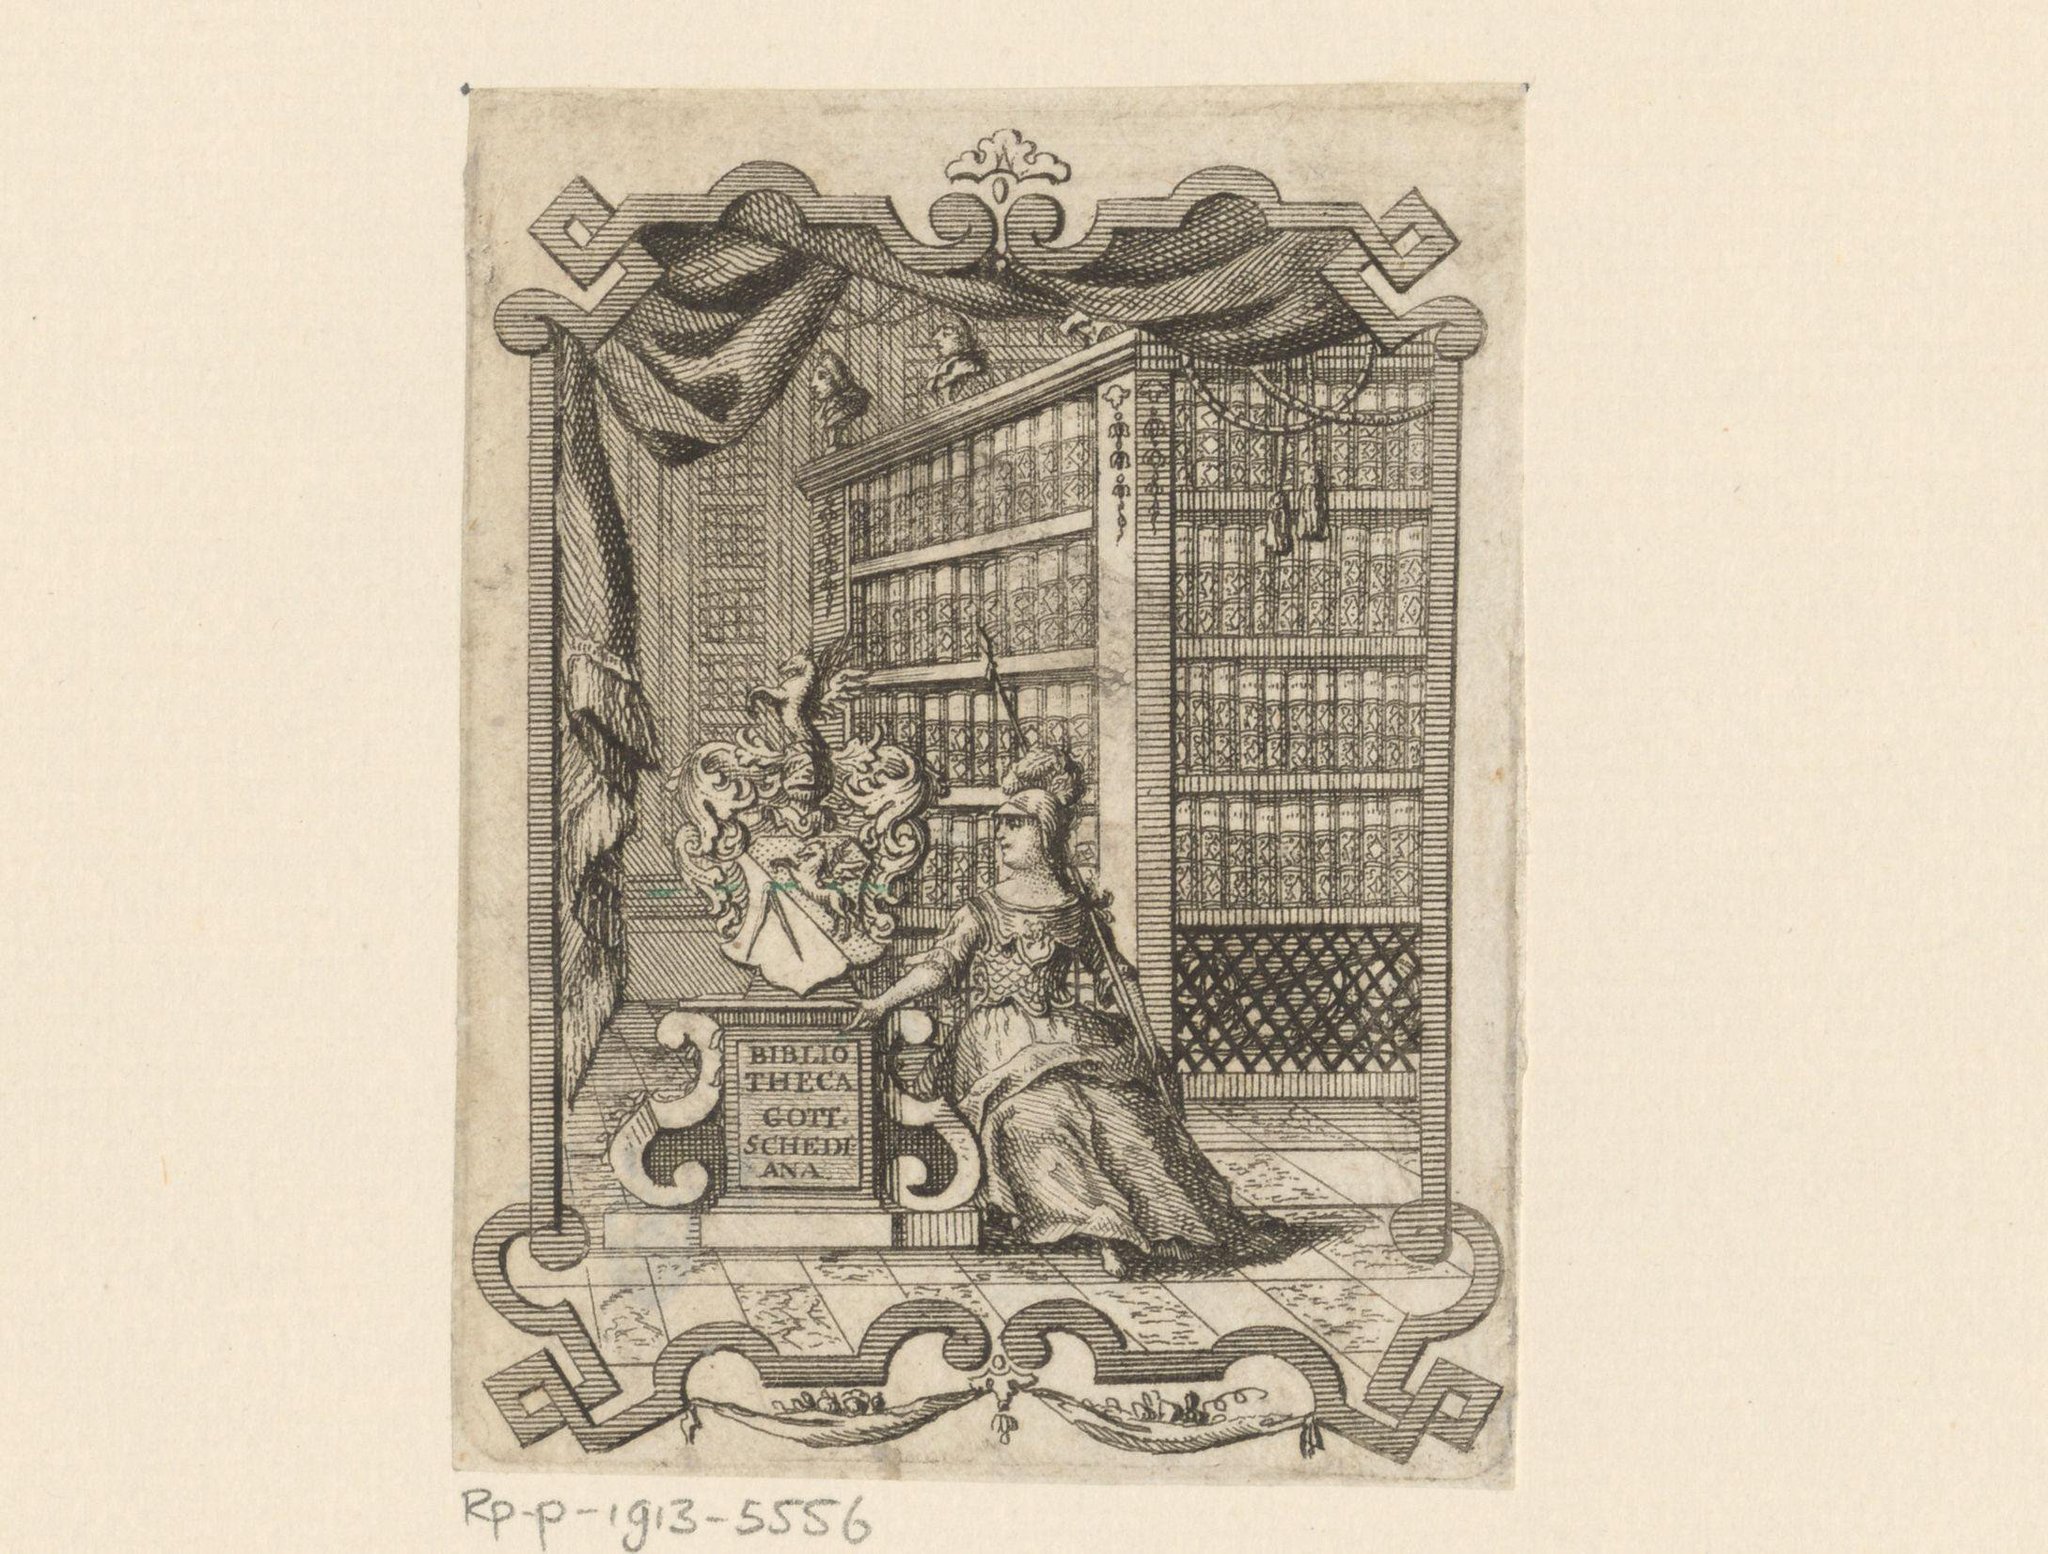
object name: bookplate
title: Ex libris van Bibliotheca Gottschediana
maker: Anonymous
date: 1710-1766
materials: paper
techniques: etching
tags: armorial bearing, heraldry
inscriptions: collector's mark: Lugt 2760, collector's mark: Lugt 2233